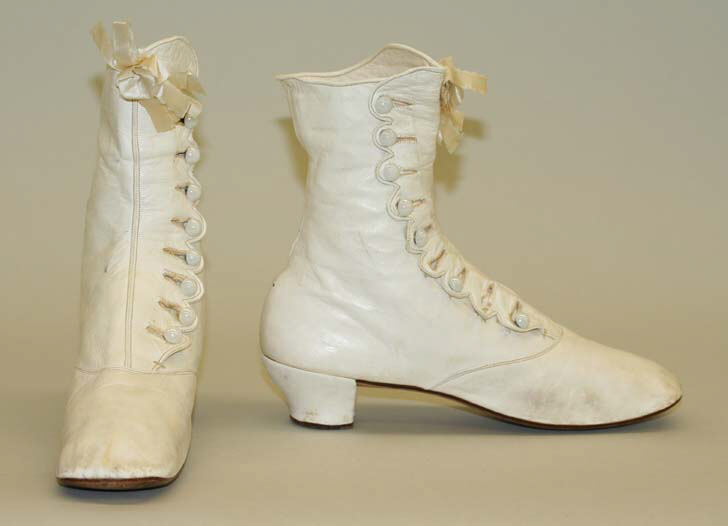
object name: shoe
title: Shoes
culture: american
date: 1875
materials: cotton, leather, silk, wood